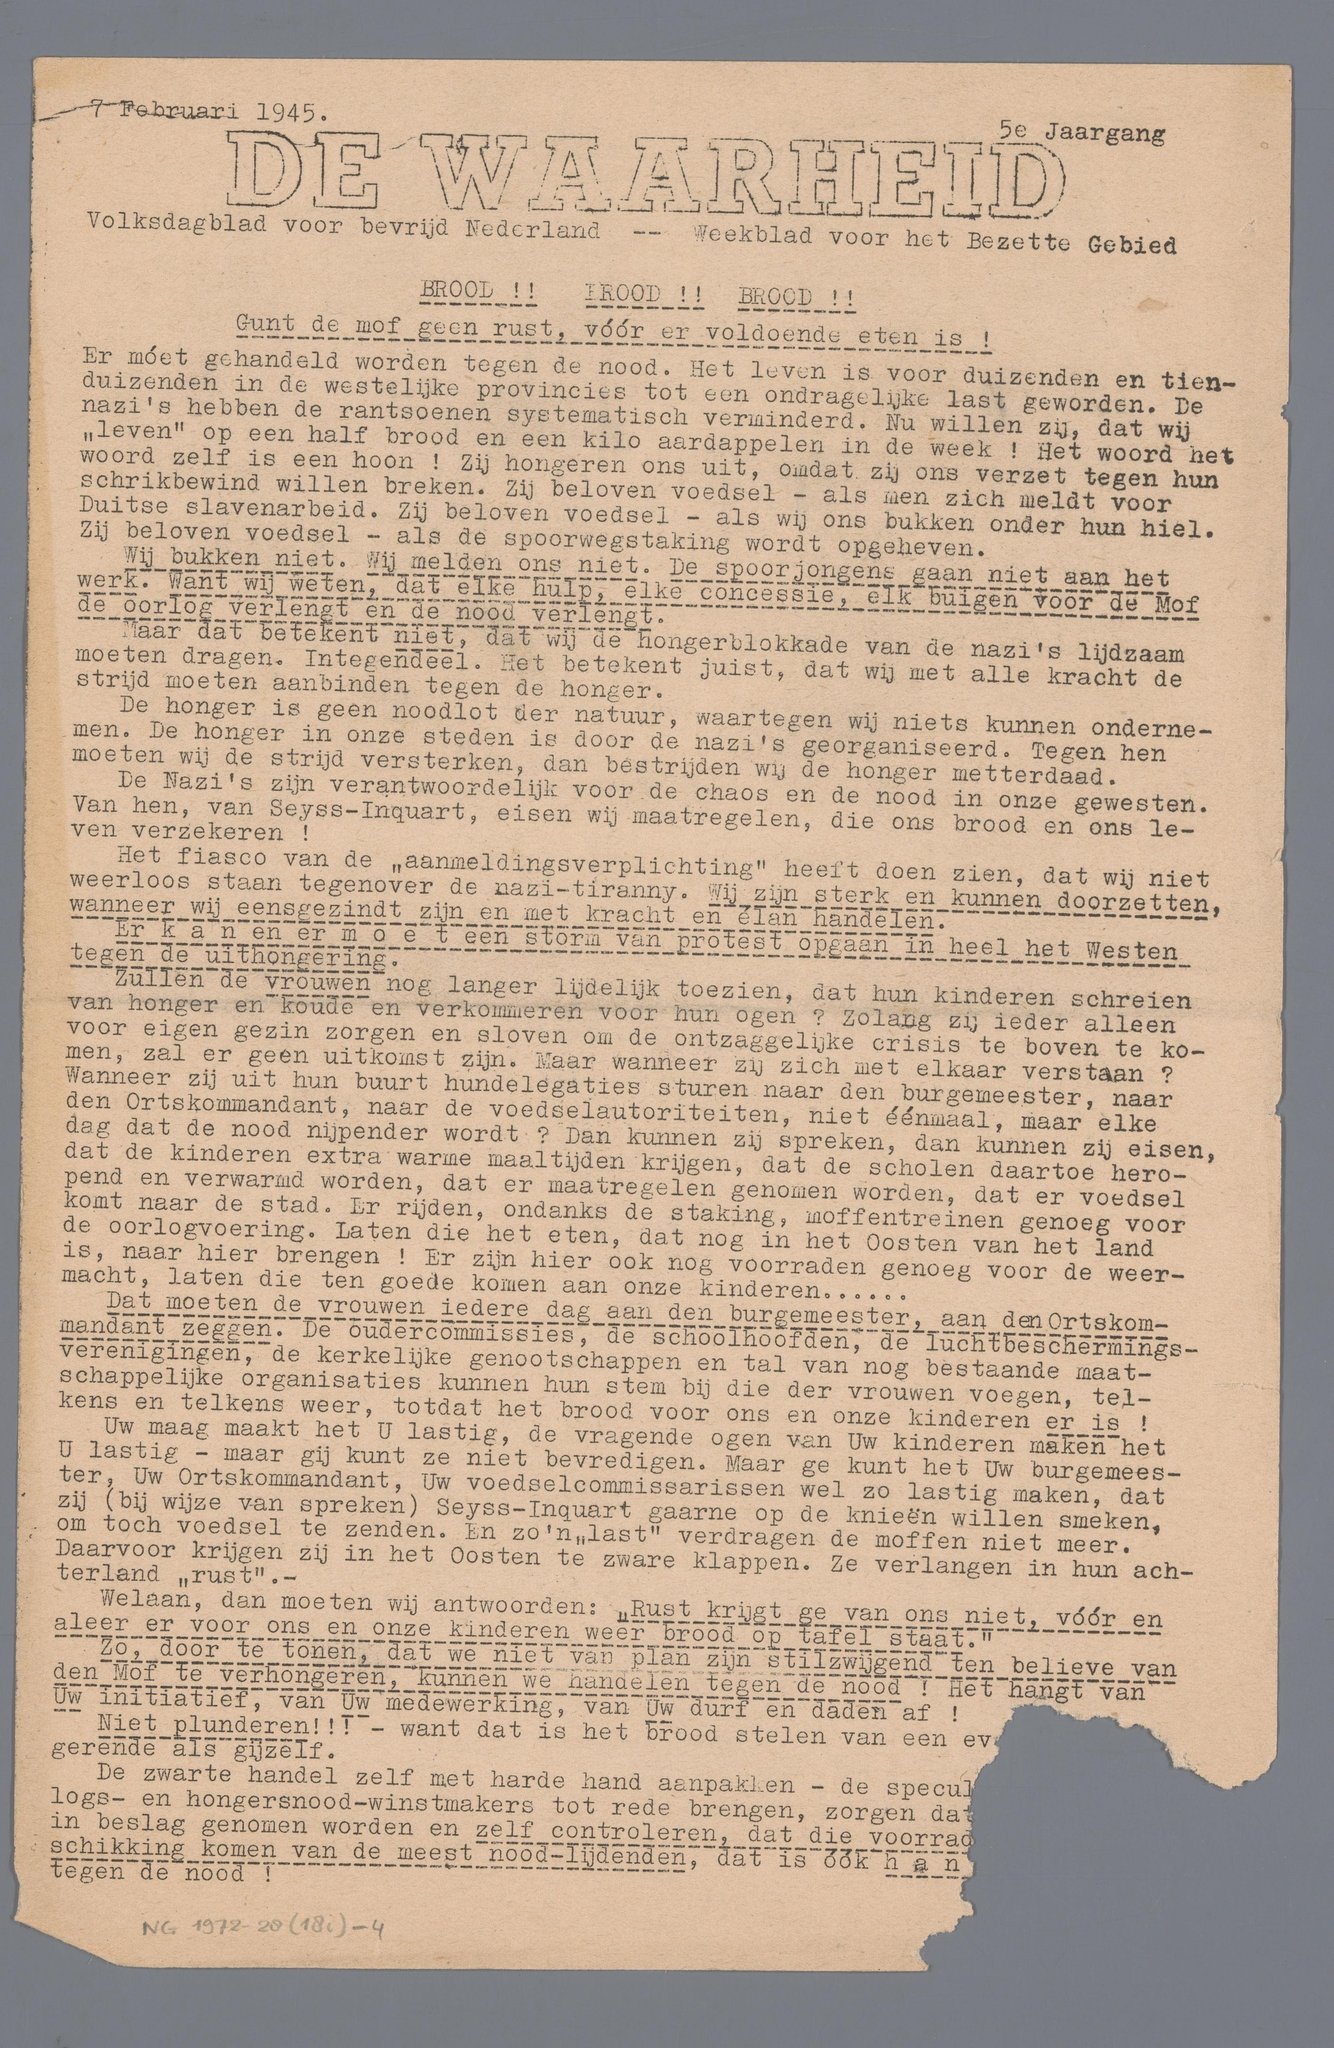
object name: newspaper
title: De Waarheid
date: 1945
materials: paper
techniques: mimeography, printing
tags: netherlands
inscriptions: date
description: Nummer van het illegale blad 'De Waarheid': 'Brood!! Brood!! Brood!!, 2pp. Opschrift; l.b.: 'Volksdagblad voor bevrijd Nederland, r.b. 'Uitgave voor het bezette gebied'. Gedateerd: boven.